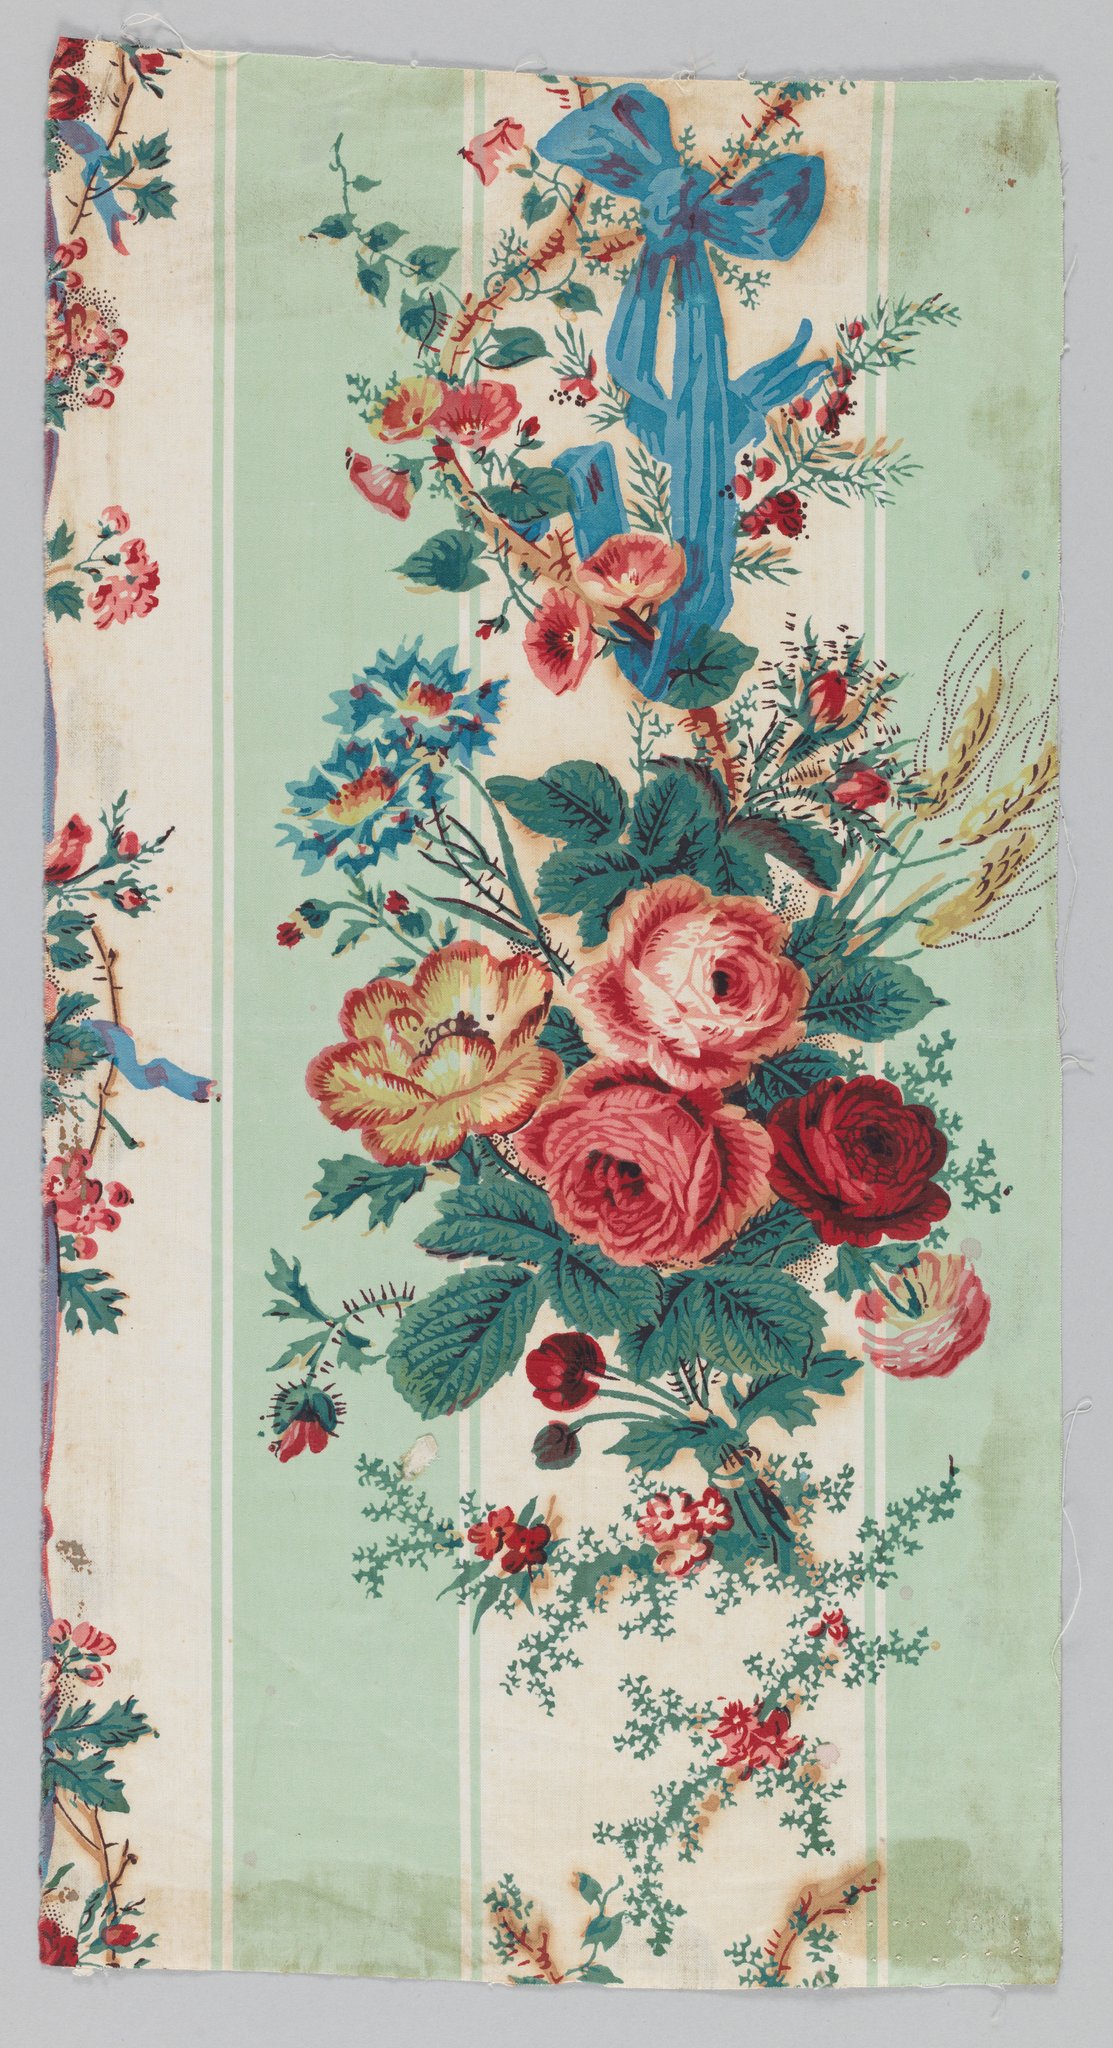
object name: piece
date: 1801-1900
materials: cotton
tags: flowers